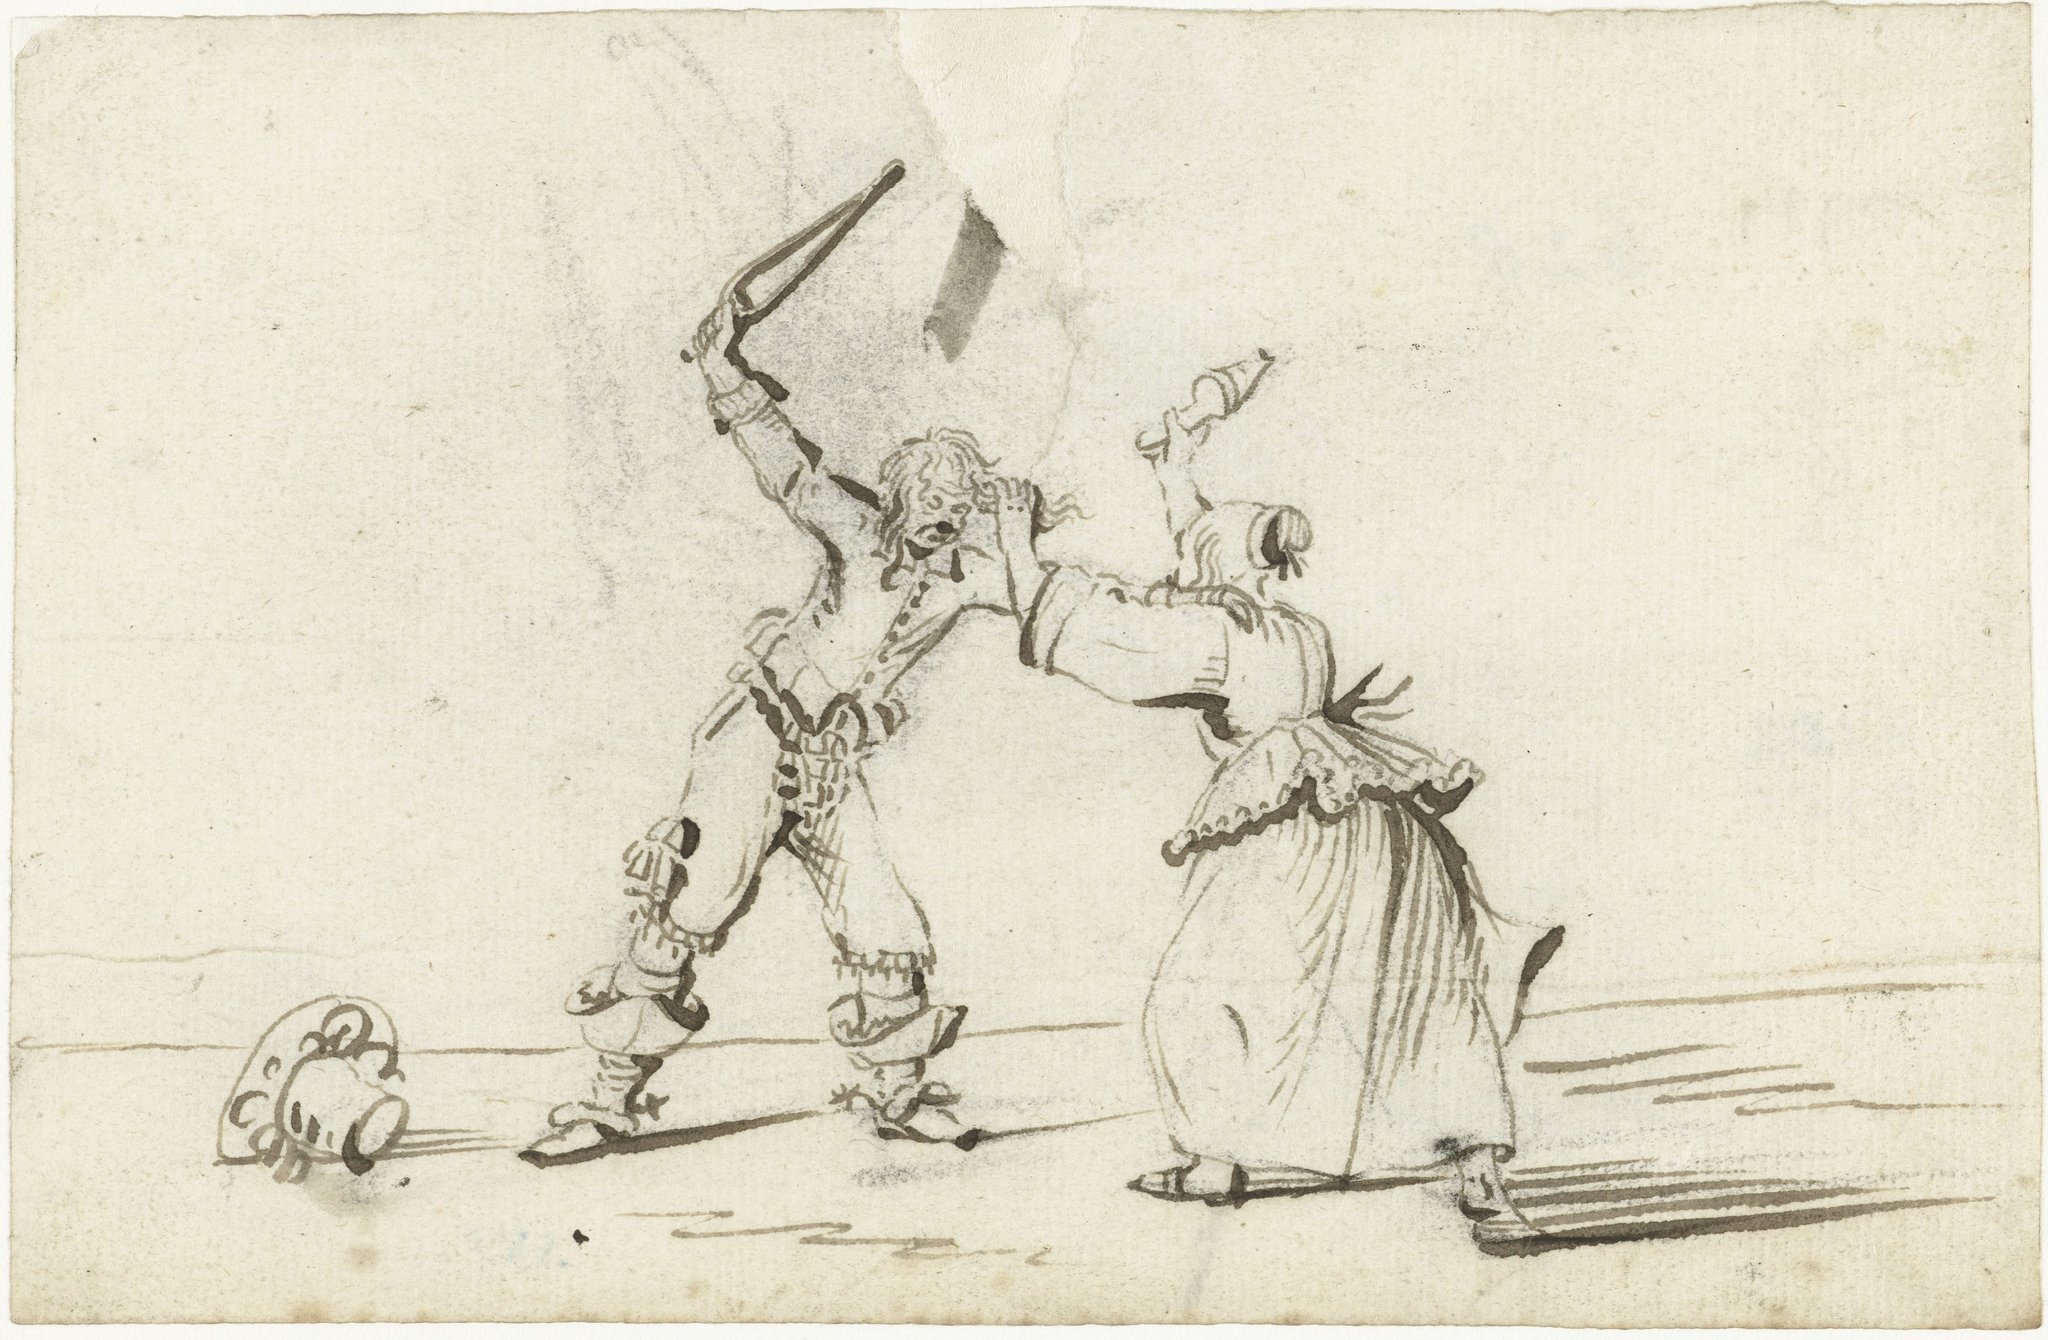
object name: drawing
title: A Domestic Quarrel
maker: gesina ter borch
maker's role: draughtsman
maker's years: 1633-1690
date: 1652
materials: chalk, ink, paper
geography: zwolle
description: This marital squabble has got quite out of hand. The man brandishes a fire iron above his head, while the woman swings her shoe and grabs his hair. No wonder his hat has fallen to the ground. This highly original and witty composition is a preliminary study for an illustration in the Poëzie-album (Poetry Album) accompanying a poem about good and bad marriages.